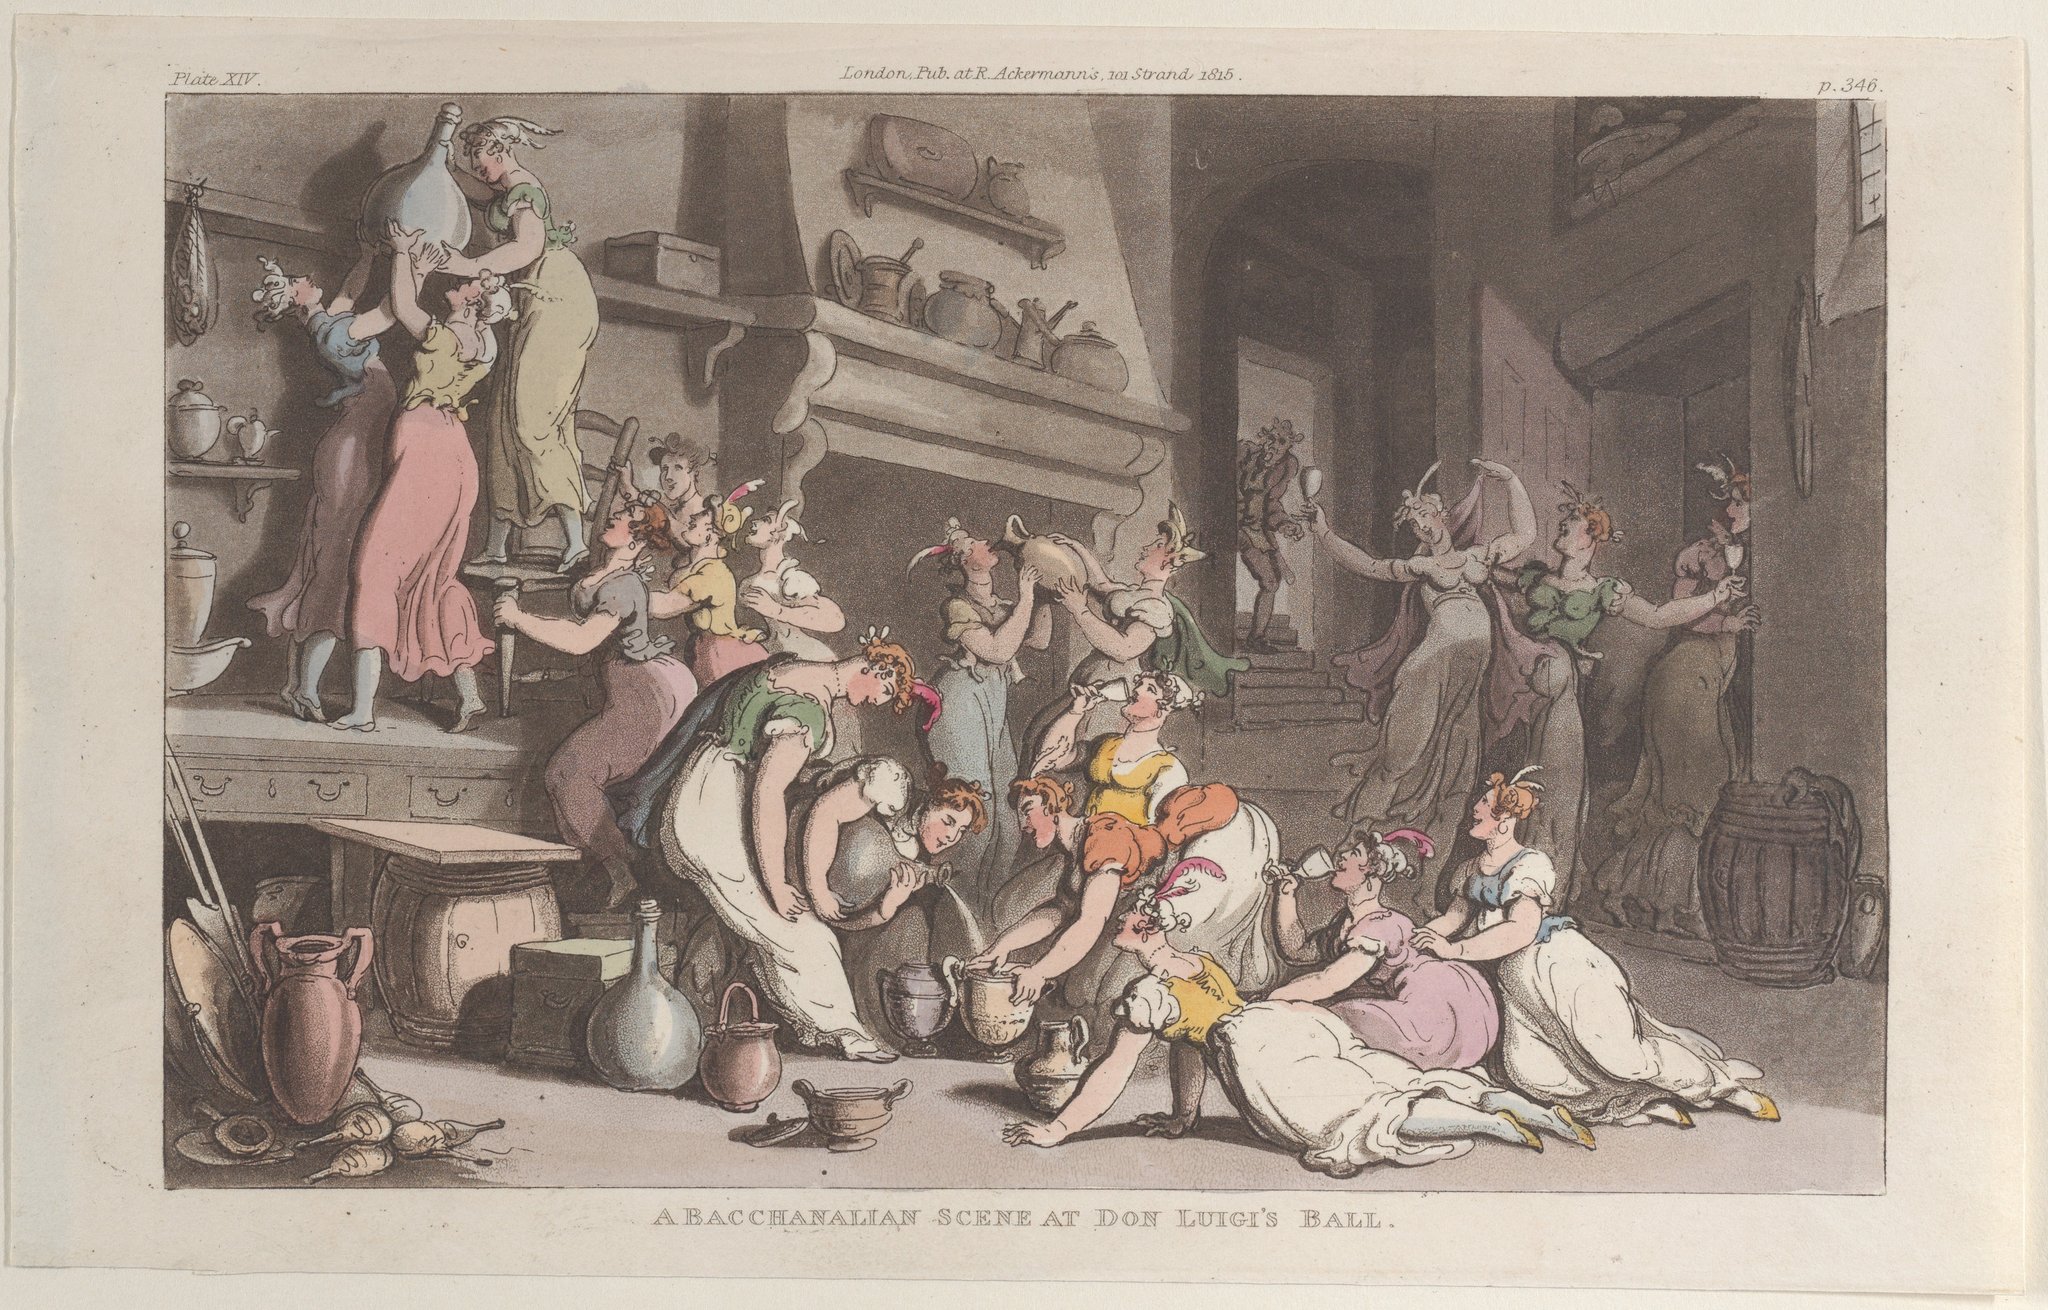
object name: print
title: A Bacchanalian Scene at Don Luigi's Ball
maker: thomas rowlandson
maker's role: artist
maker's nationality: british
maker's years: 1757-1827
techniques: aquatint, etching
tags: kitchens,women,drinking